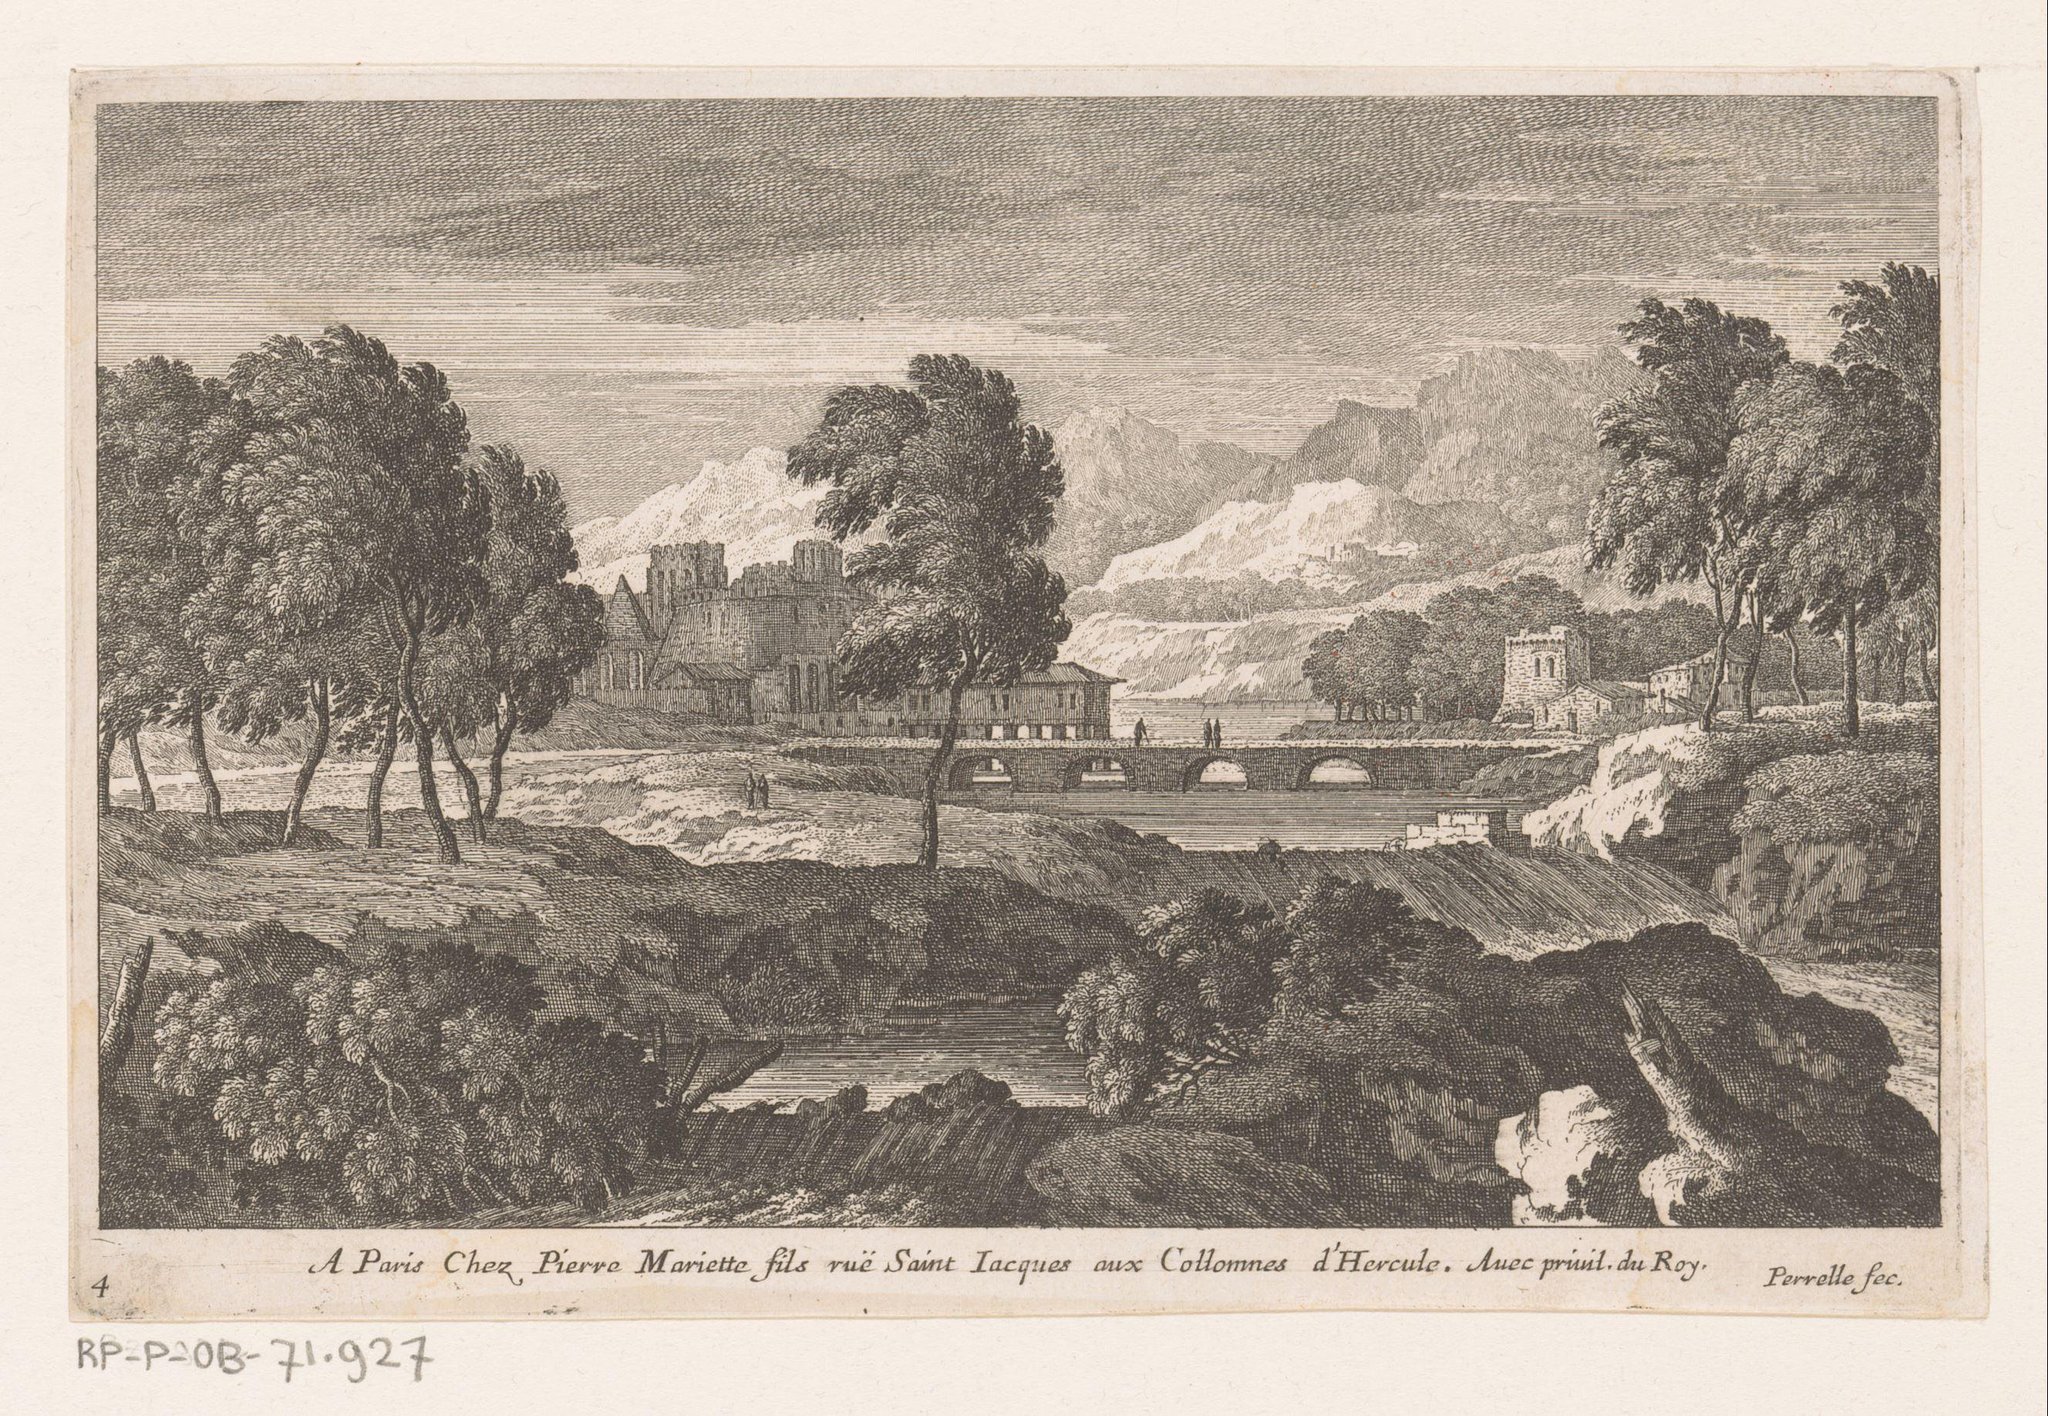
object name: print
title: Landschap met brug met vier bogen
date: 1613-1695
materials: paper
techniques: etching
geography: france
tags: landscape with bridge, viaduct or aqueduct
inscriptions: collector's mark: Lugt 240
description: Prenten met het signatuur 'Perelle' kunnen zowel door vader Gabriel als door zonen Nicolas en Adam gemaakt zijn.